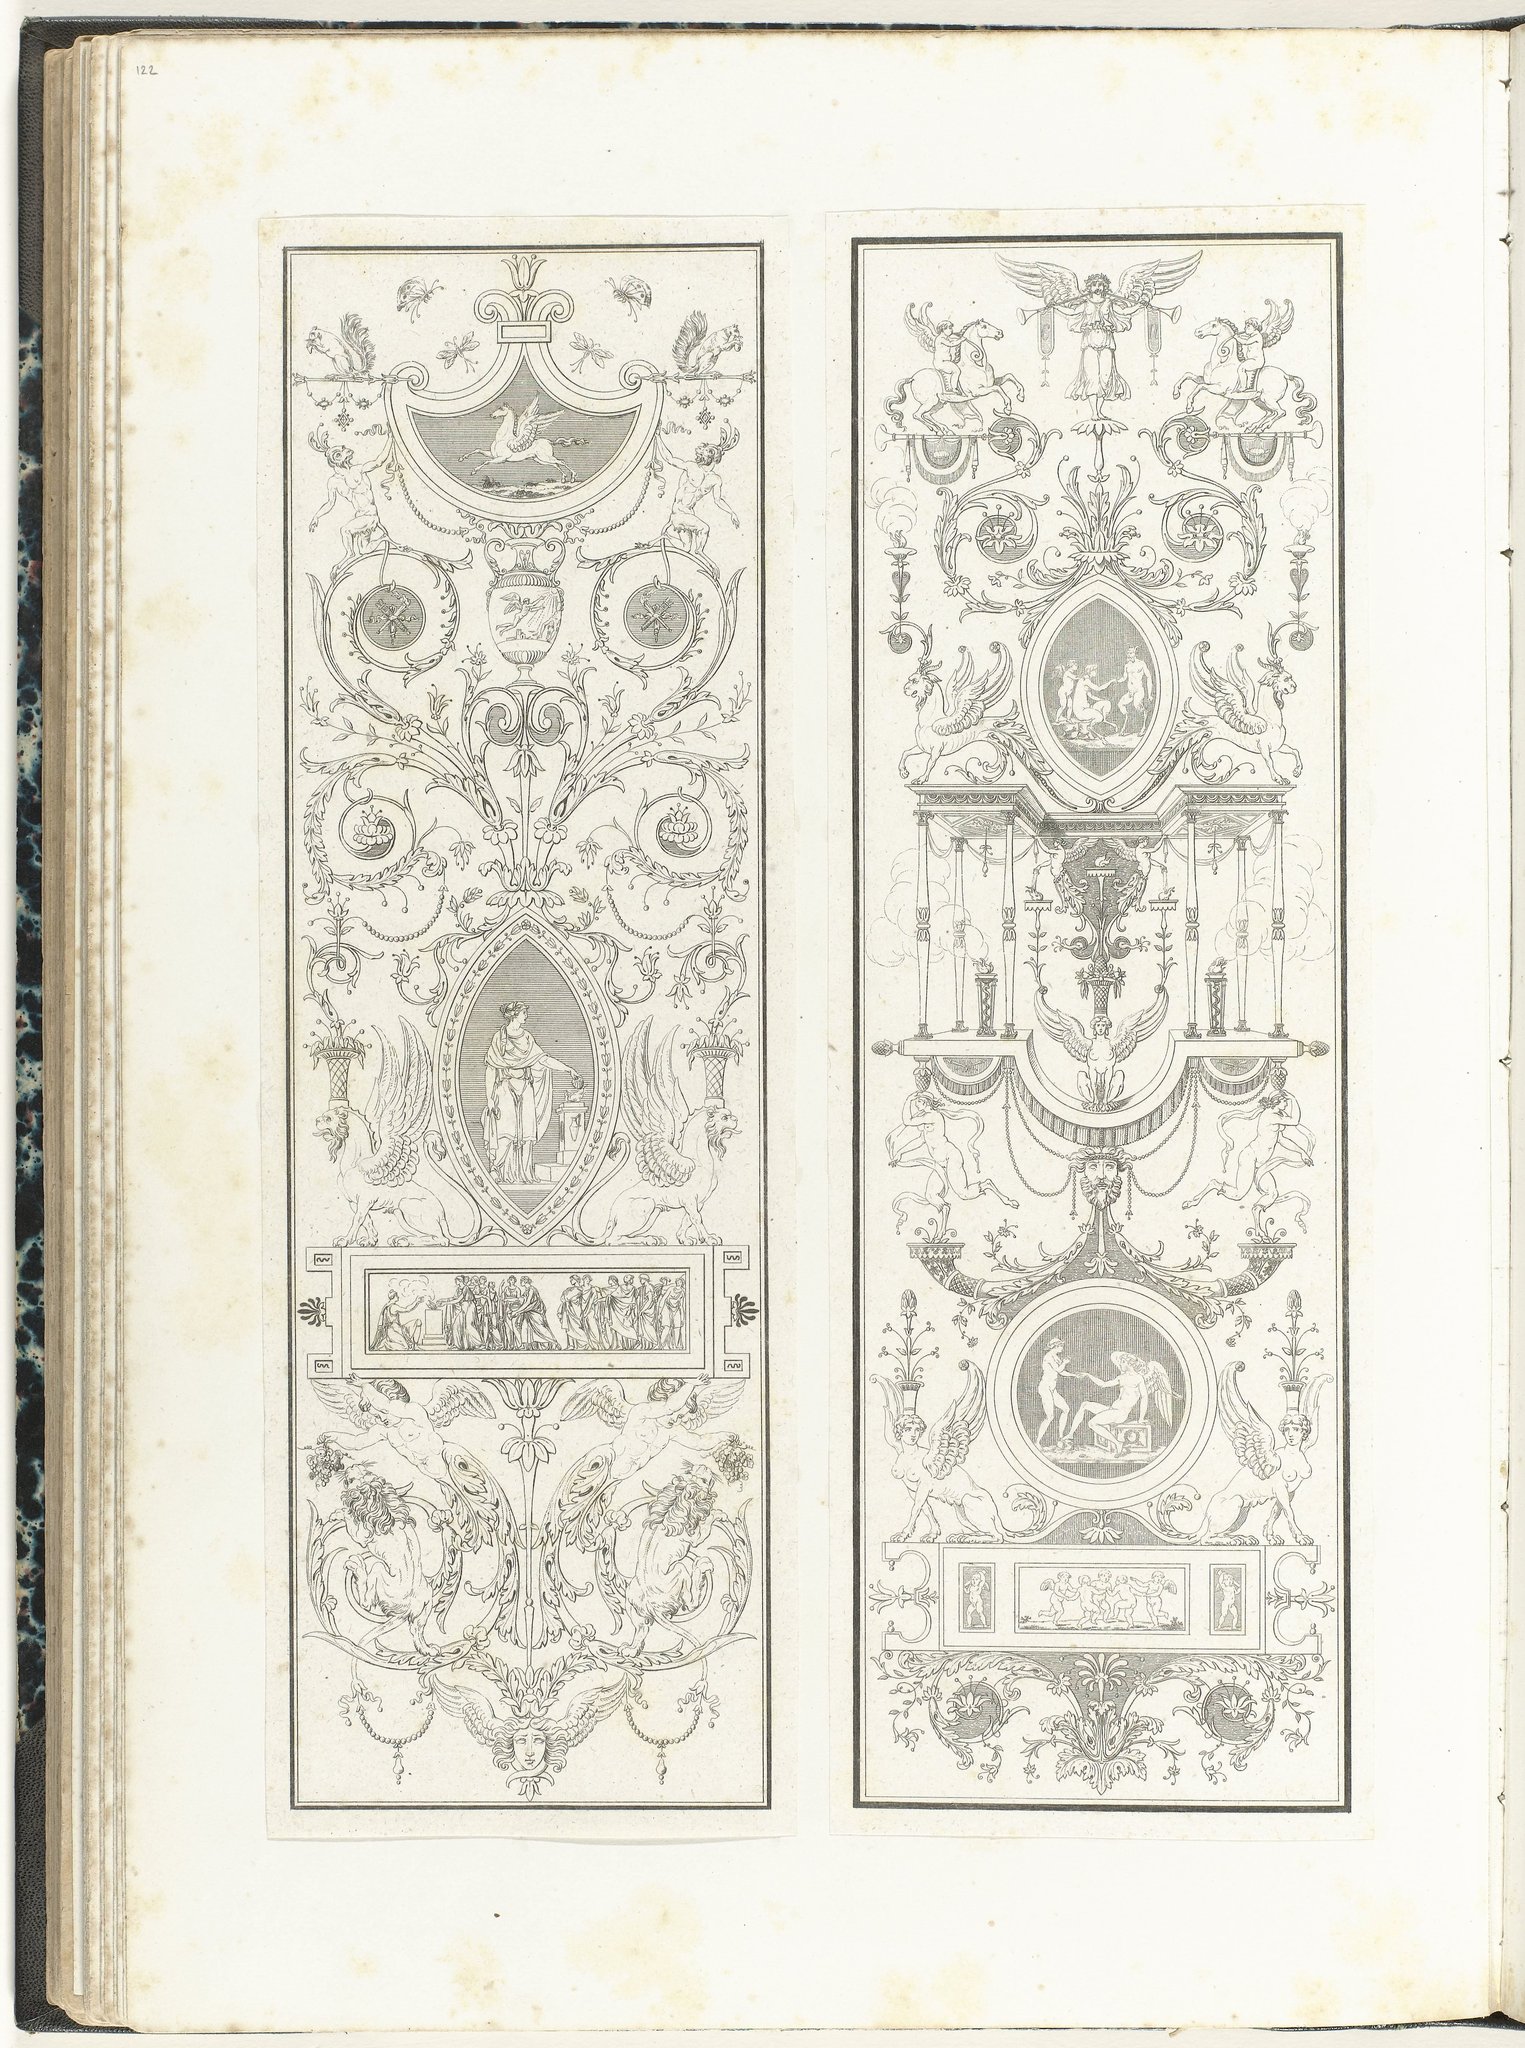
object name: print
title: Twee panelen met moderne grotesken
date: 1866-1900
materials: paper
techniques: lithograph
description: Op het linkerpaneel hangt bovenaan een schild met een gevleugeld paard, op het rechterpaneel hangt bovenaan een puntig ovaal medaillon met een satervrouw, saterman en putto.